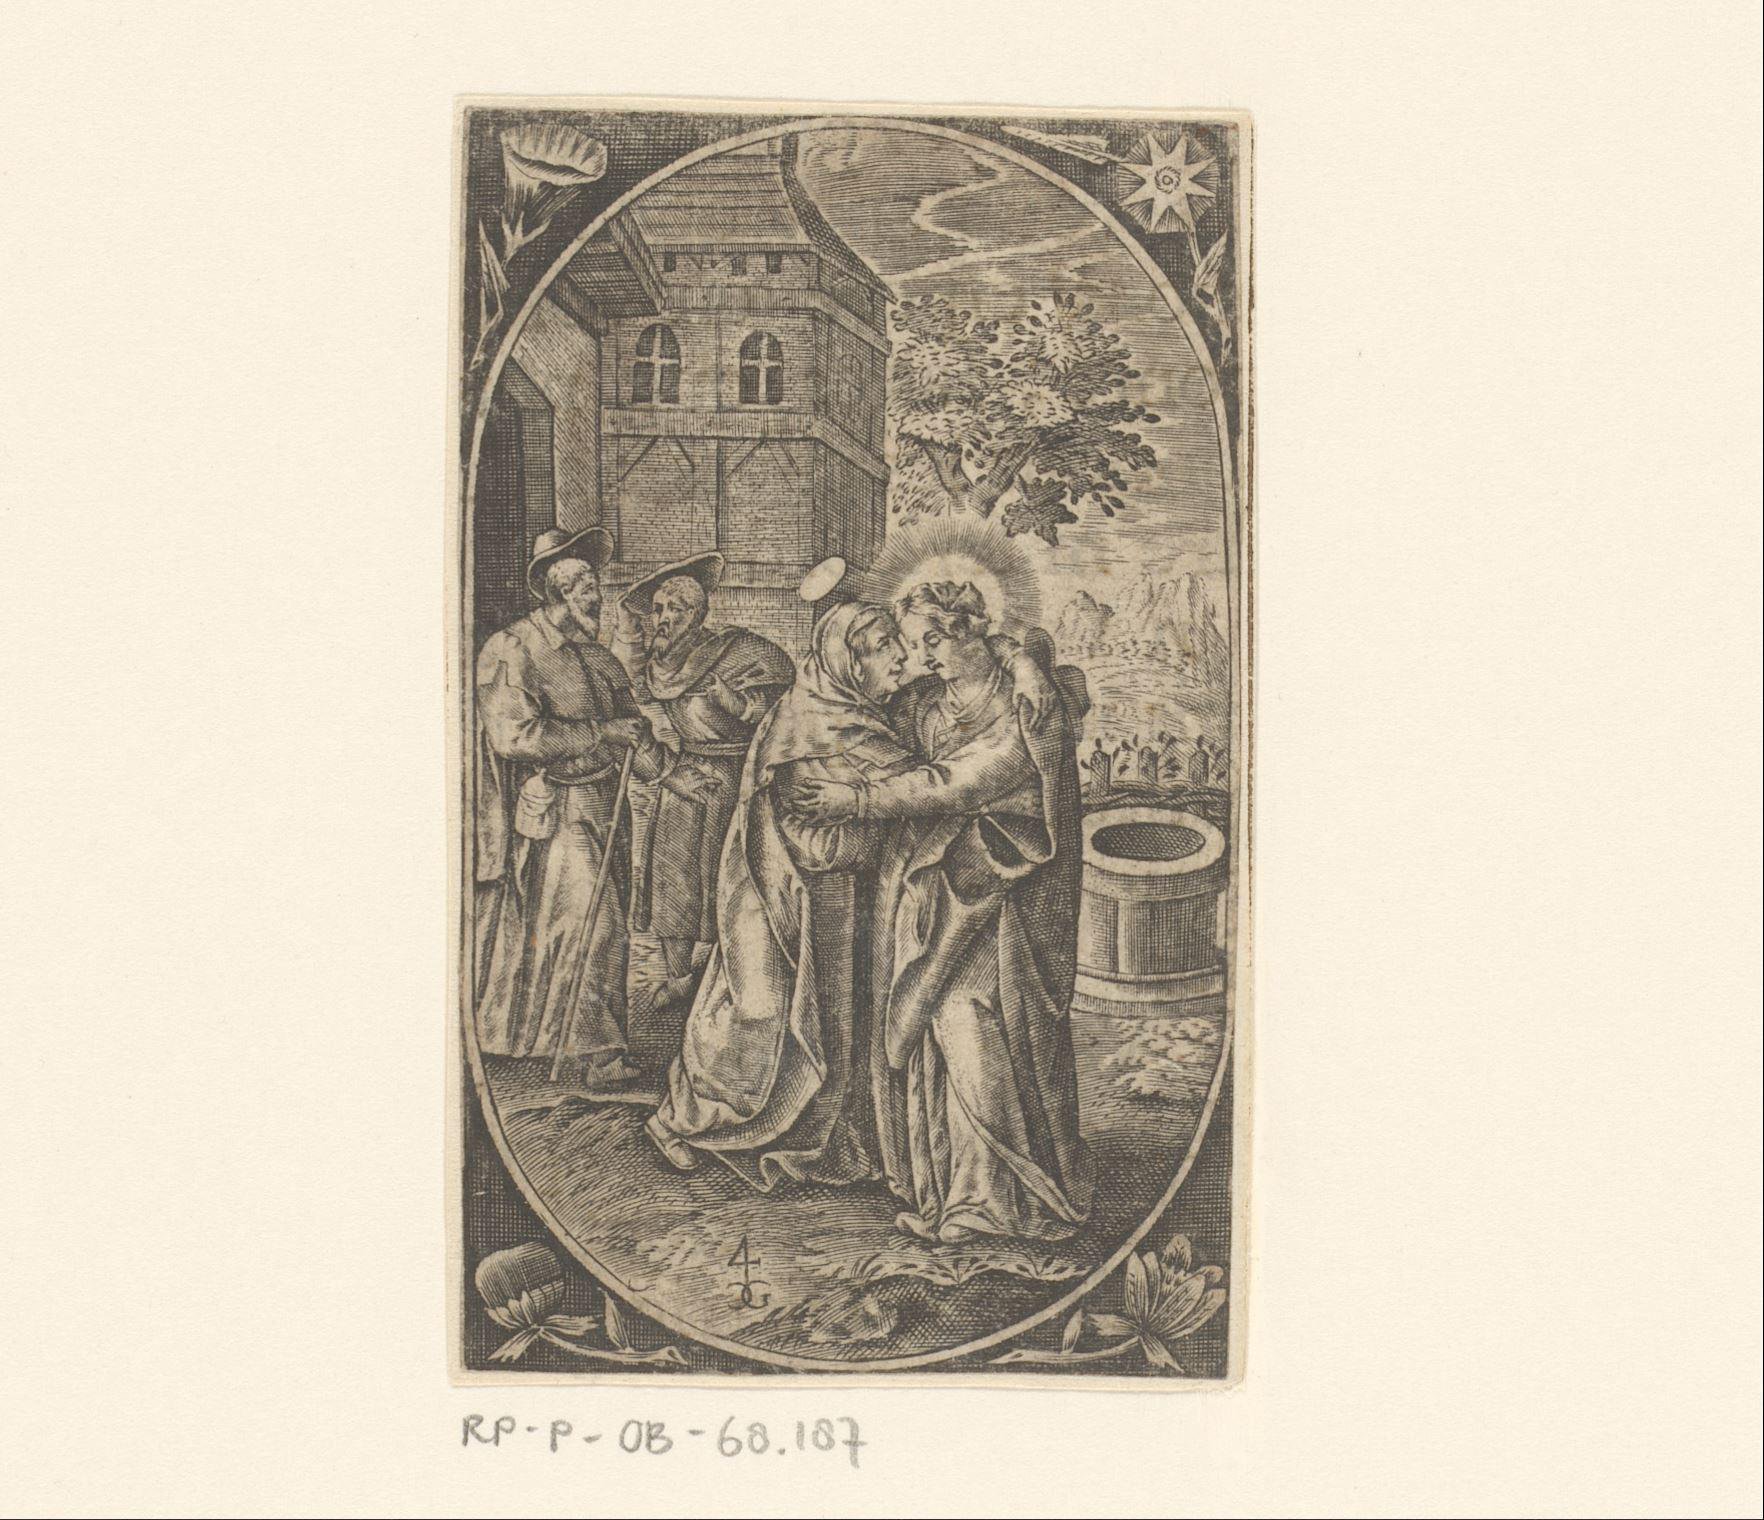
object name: print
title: Visitatie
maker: monogrammist cg (16e eeuw)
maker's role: print maker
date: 1550-1600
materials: paper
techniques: engraving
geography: low countries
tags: mary and elisabeth, both pregnant, embracing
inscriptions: collector's mark: Lugt 2227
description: Maria en haar nicht Elisabet omhelzen elkaar bij een waterput. Jozef en Zacharias praten met elkaar op de achtergrond. Rondom verschillende bloemen.